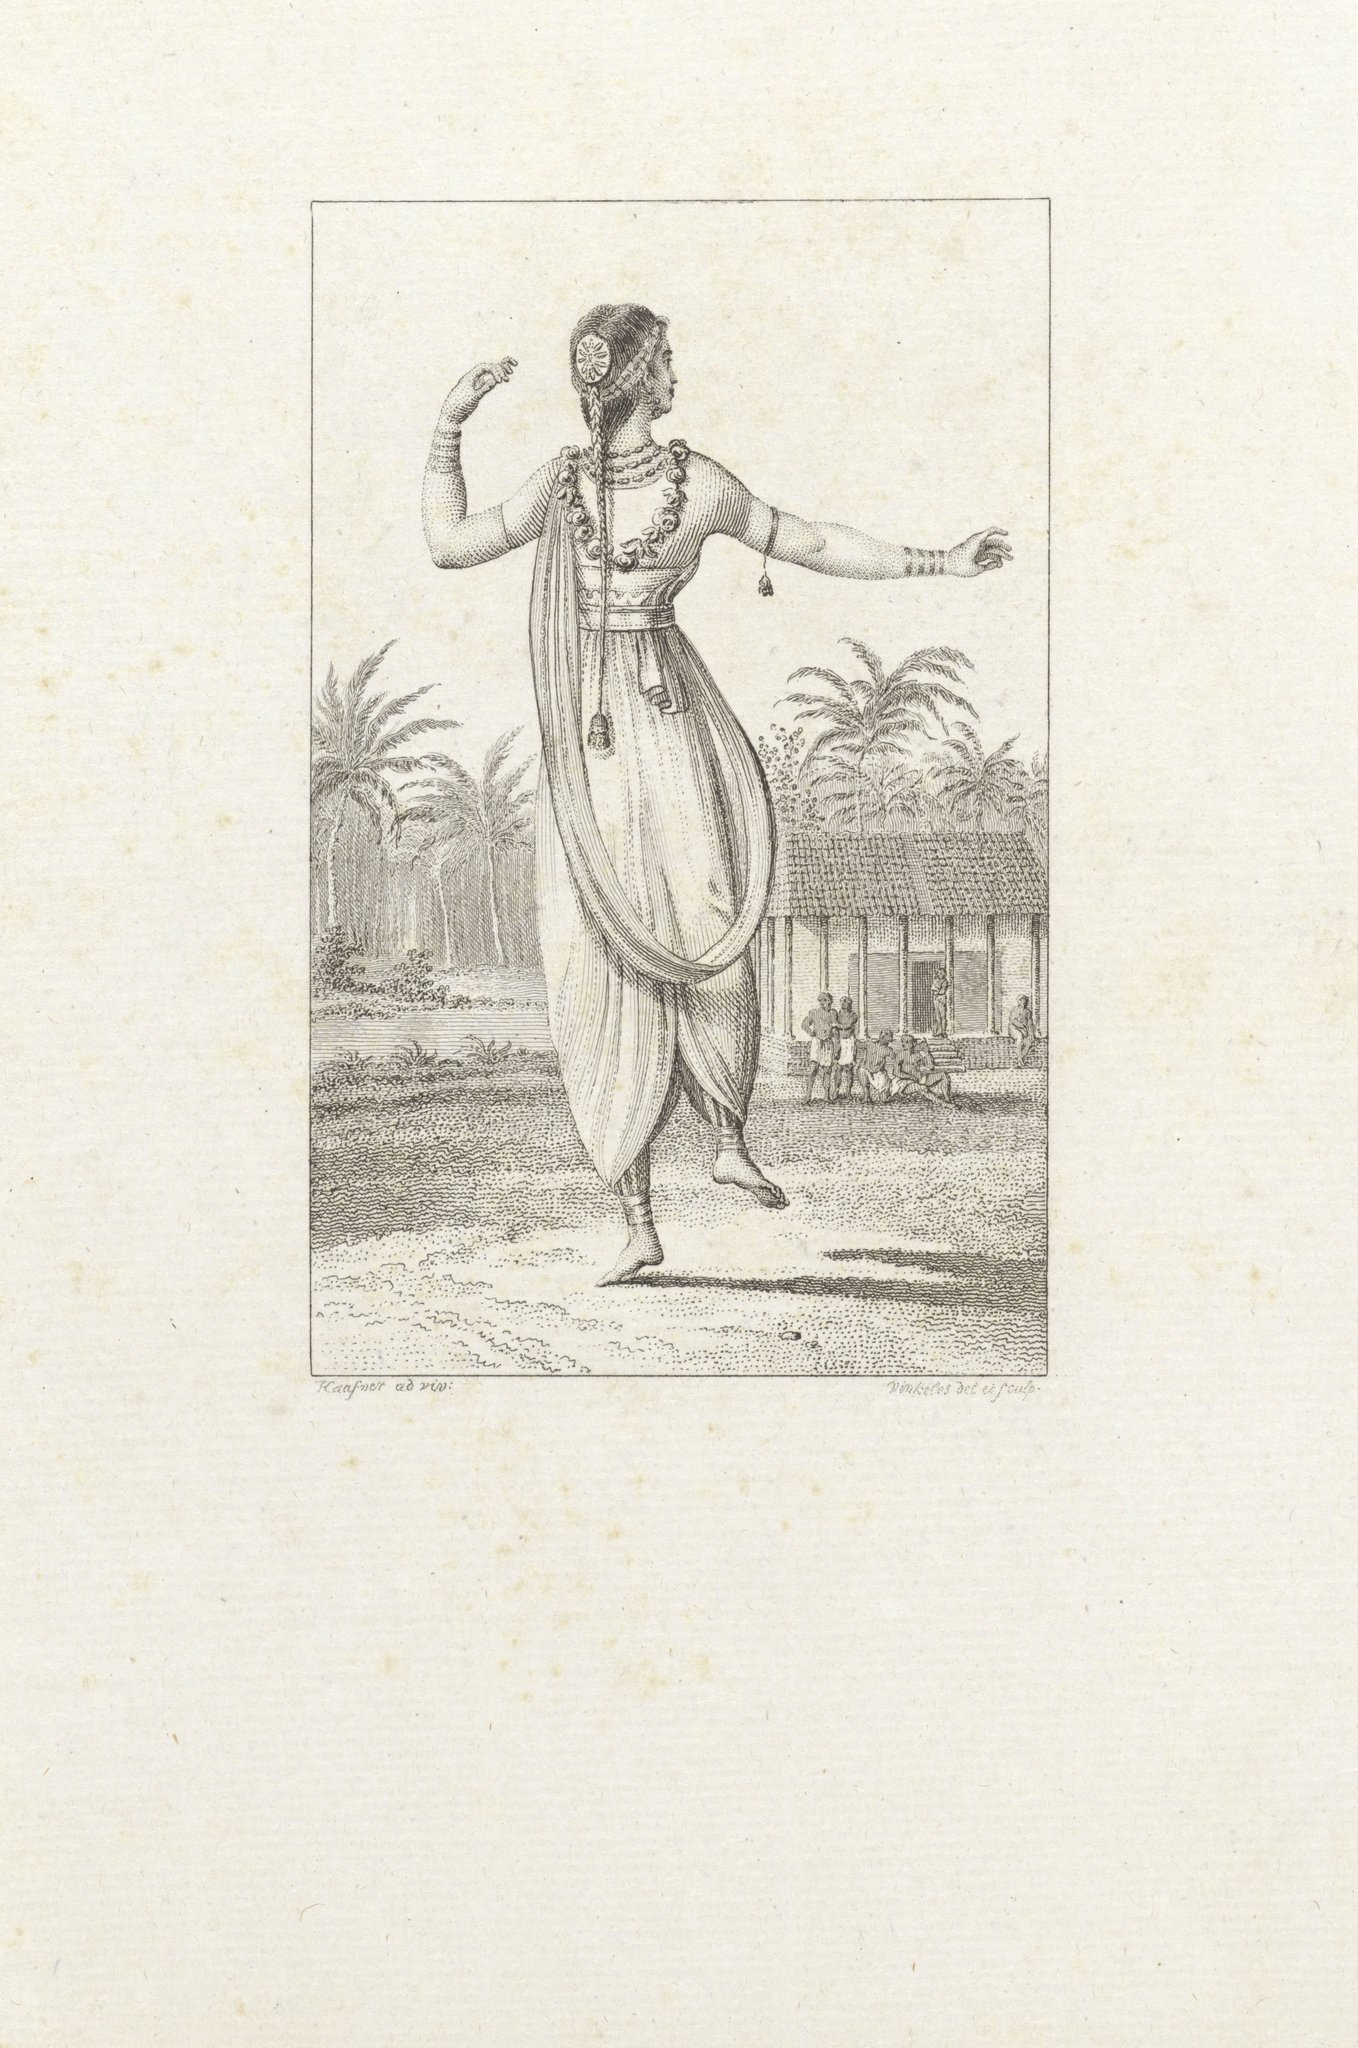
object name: print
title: Zuidoost-Aziatische danseres van achteren gezien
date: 1808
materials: paper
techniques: engraving, etching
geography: amsterdam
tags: asiatic races and peoples, woman dancing alone, female dancer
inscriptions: collector's mark: Lugt 2228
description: Latere staat gebruikt als illustratie: Haafner, Jacob Godfried. Reizen in eenen Palaquin of Lotgevallen en merkwaardige aanteekeningen op eene reize langs de kusten Orixa en Choromandel. Deel I. Amsterdam: Johannes Allart, 1808.